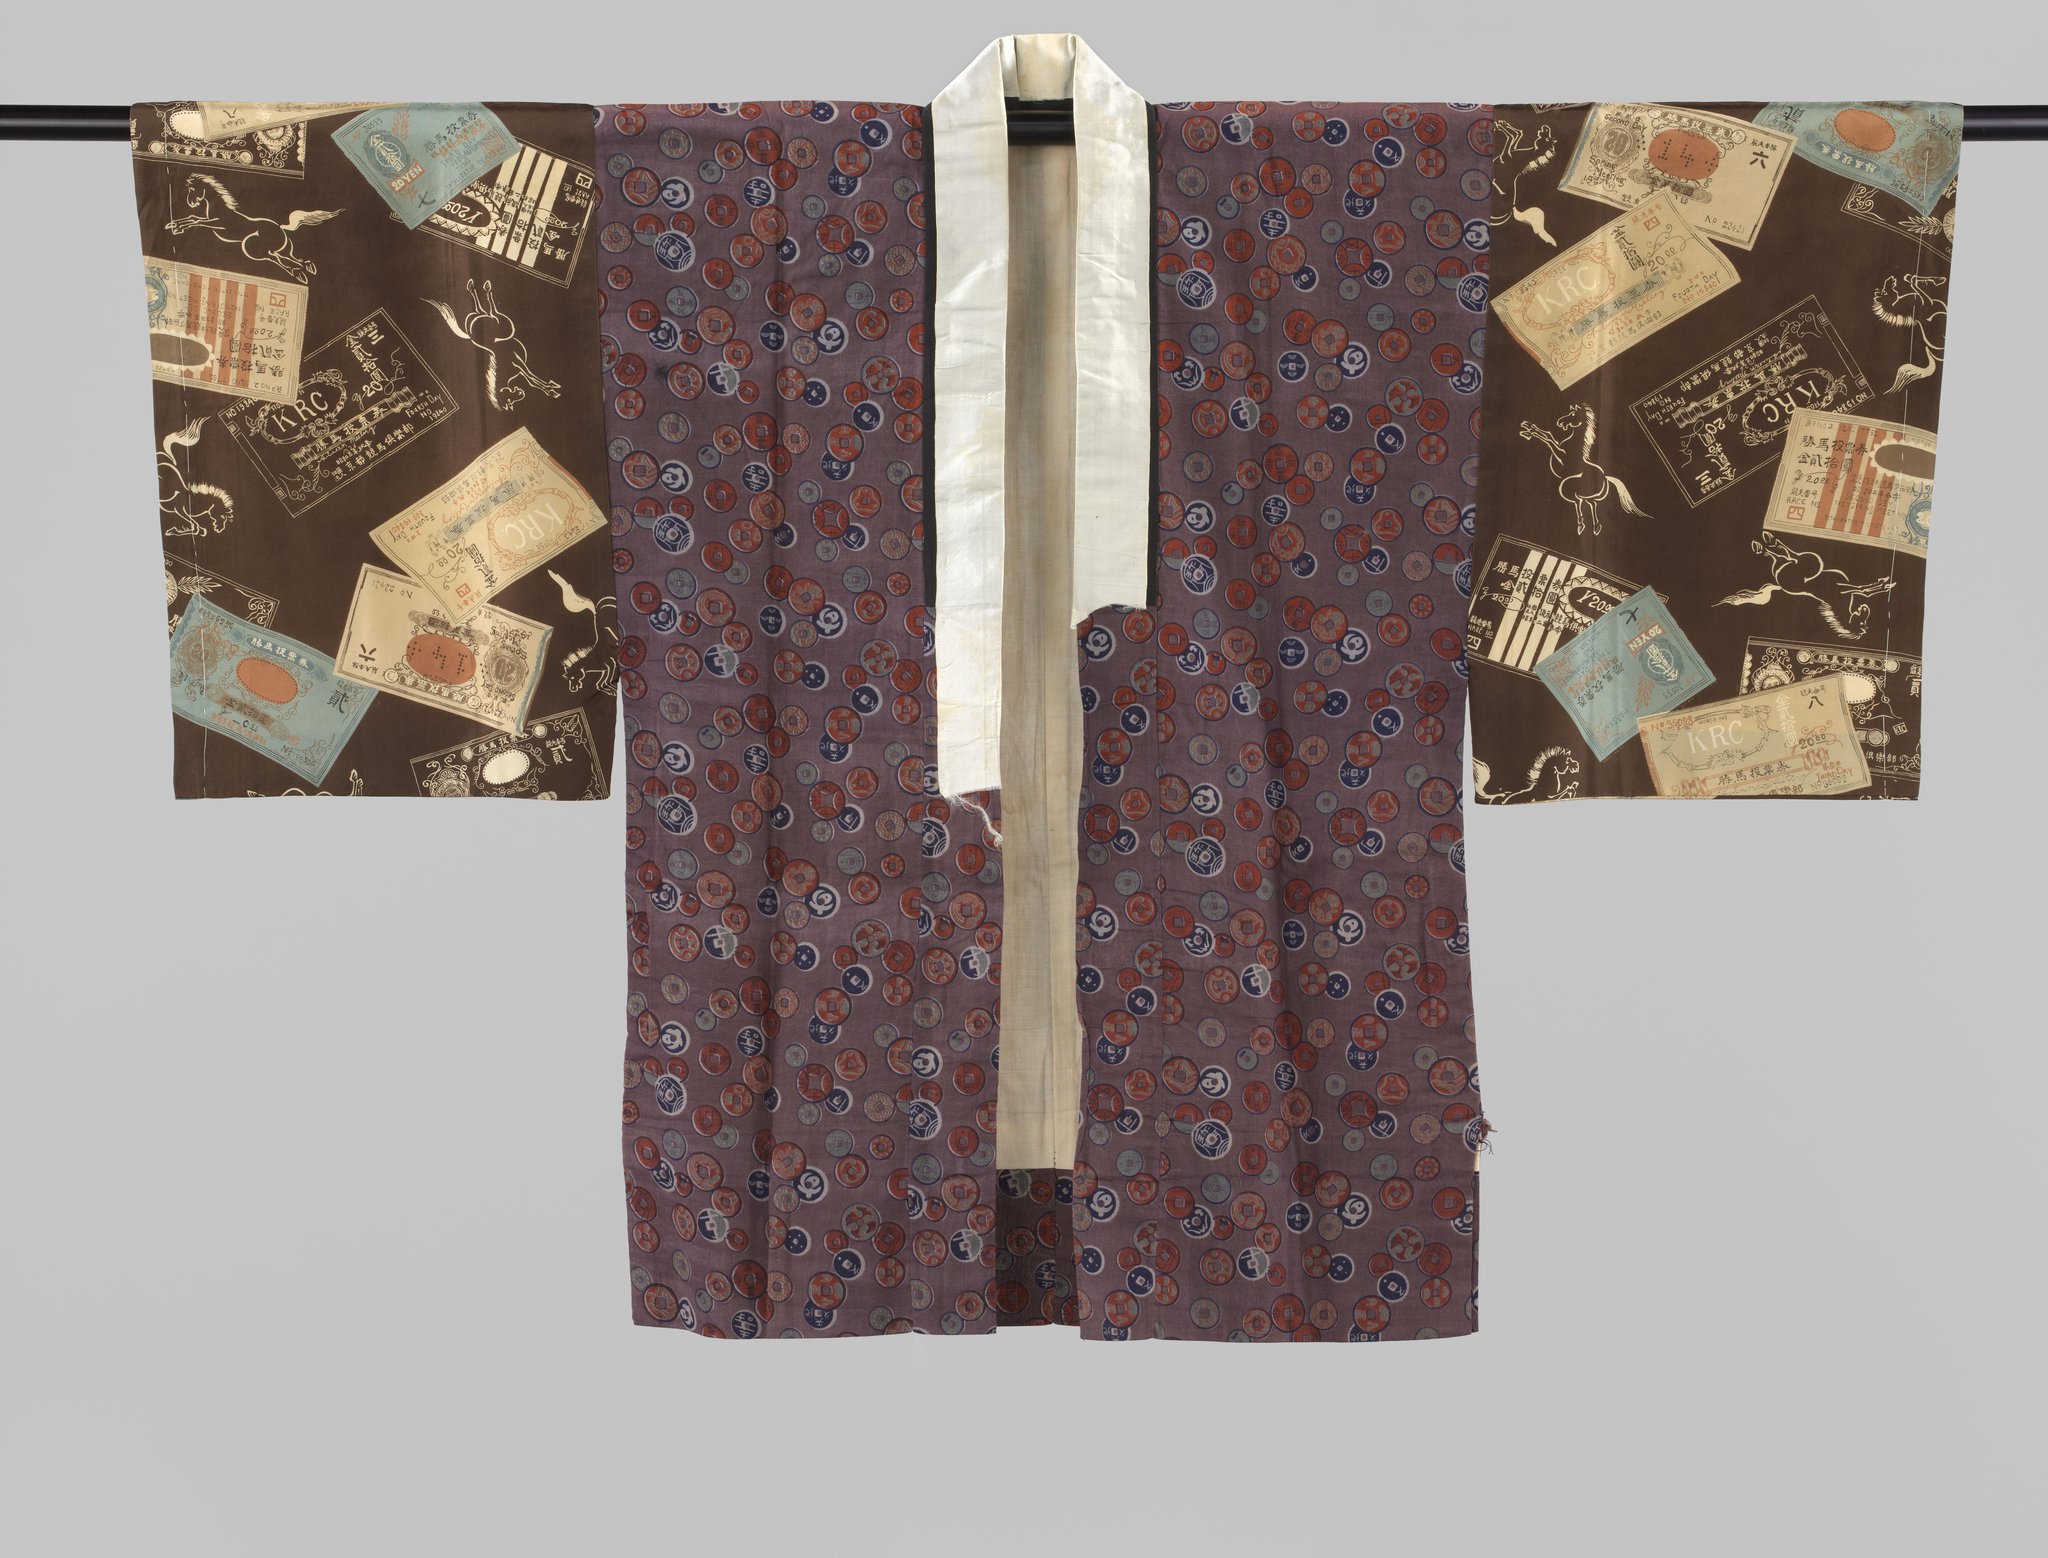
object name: kimono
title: Mannen hanjuban met paarden race motieven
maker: Anonymous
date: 1926-1927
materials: cotton, silk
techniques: painting, weave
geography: japan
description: Half-lengte onderkimono (hanjuban) voor een man met een versiering op de voor- en achterpanden van een patroon van munten, met op de mouwen afbeeldingen van paarden en wed kaarten van 20 yen voor het seizoen 1926-1927. Het KCR op de kaarten staat wellicht voor Kyoto Racing Club. Katoen en zijde (mouwen) met gestencilde yuzen versiering. Voering van witte katoen en ivoorkleurige zijde (mouwen).